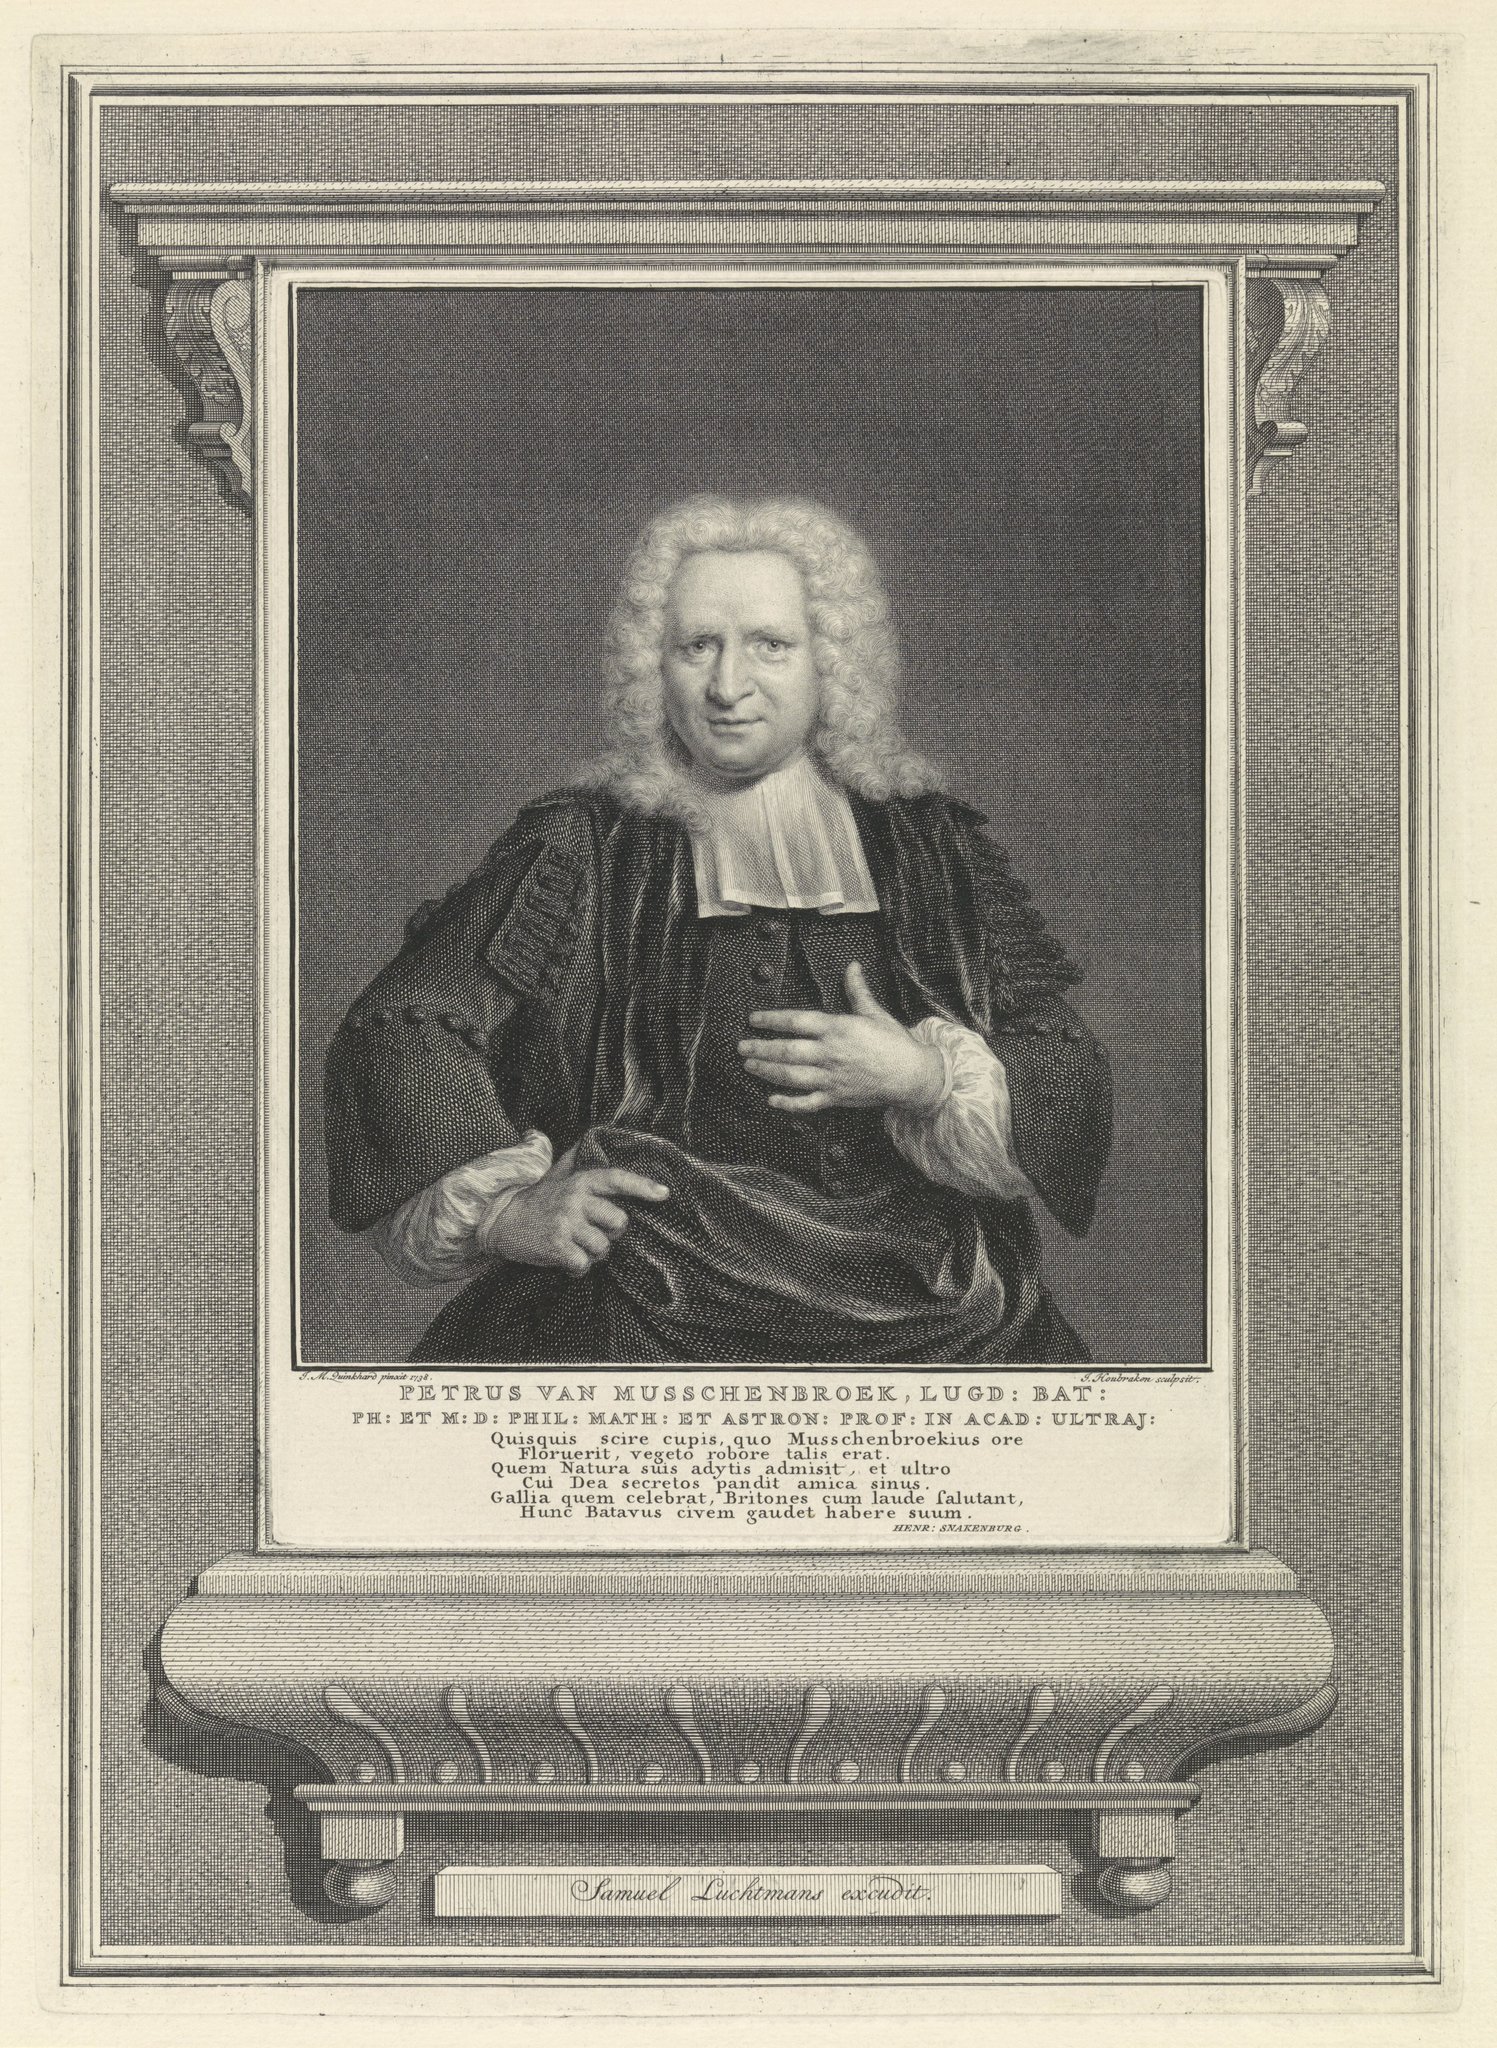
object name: print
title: Petrus van Musschenbroek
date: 1738-1755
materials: paper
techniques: engraving, etching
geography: leiden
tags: leiden, physicist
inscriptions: collector's mark: Lugt 2228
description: Portret ten halven lijve van Petrus van Musschenbroek. Onder het portret zijn naam en gegevens in twee regels in het Latijn en daaronder een zesregelige tekst in het Latijn. Rond het portret een afdruk van een tweede plaat met een omlijsting met een boven- en onderversiering om het portret.